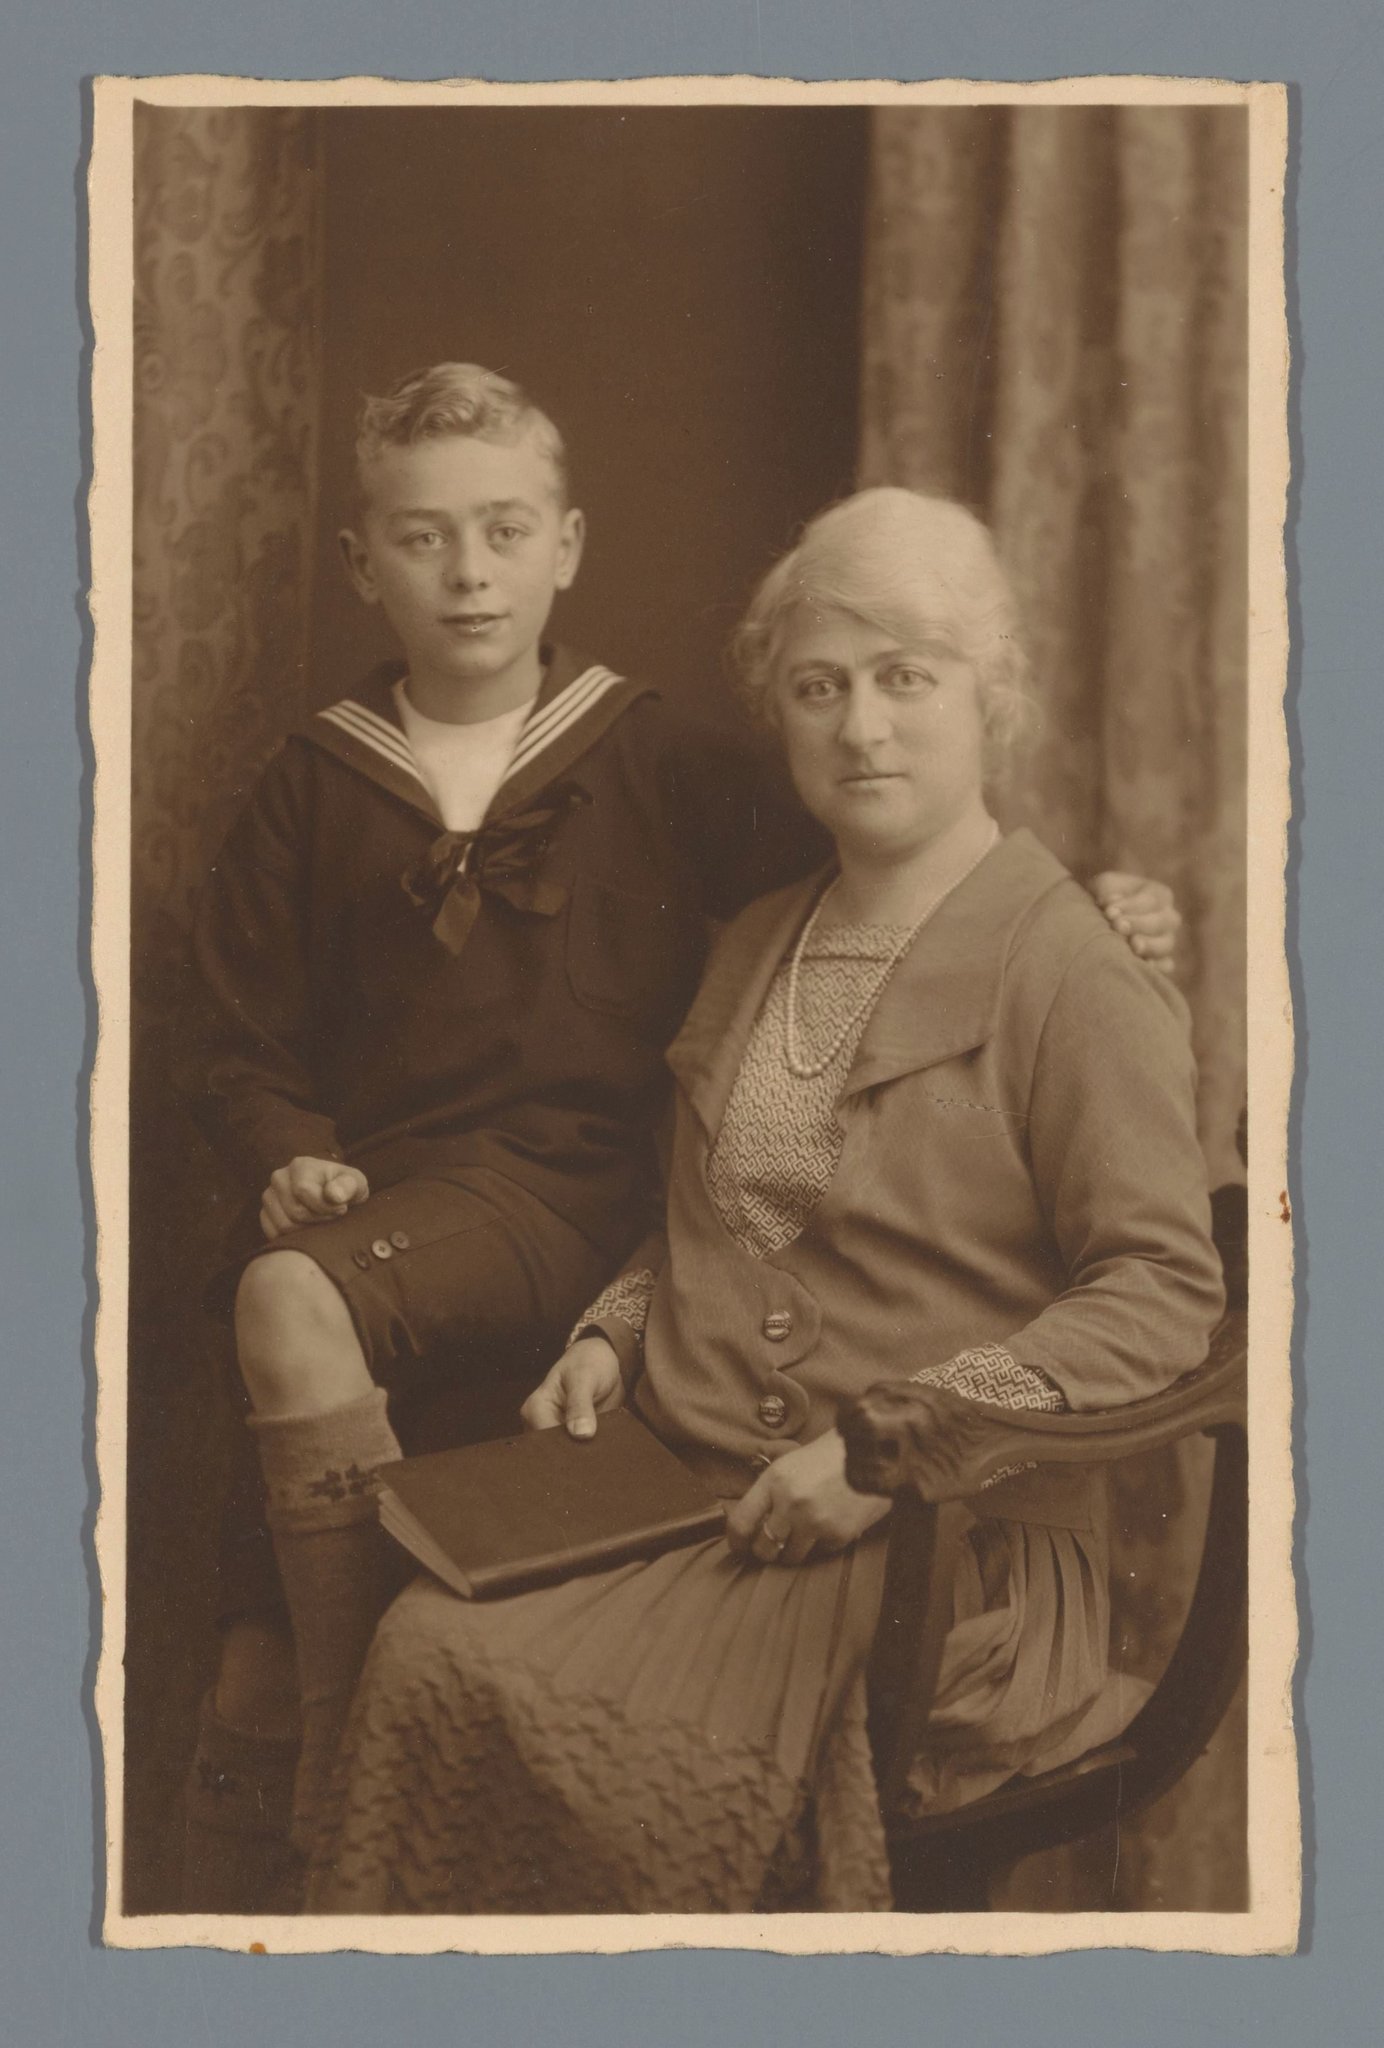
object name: photograph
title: Studioportret van een onbekende oudere vrouw en een jongen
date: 1915-1930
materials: photographic support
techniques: gelatin silver print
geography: amsterdam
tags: grandparent(s) with grandchild(ren) (family group)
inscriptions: inscription: ‘Foto ,,Prinses'' Kalverstraat, 103, Amsterdam, Telef. 37017.’